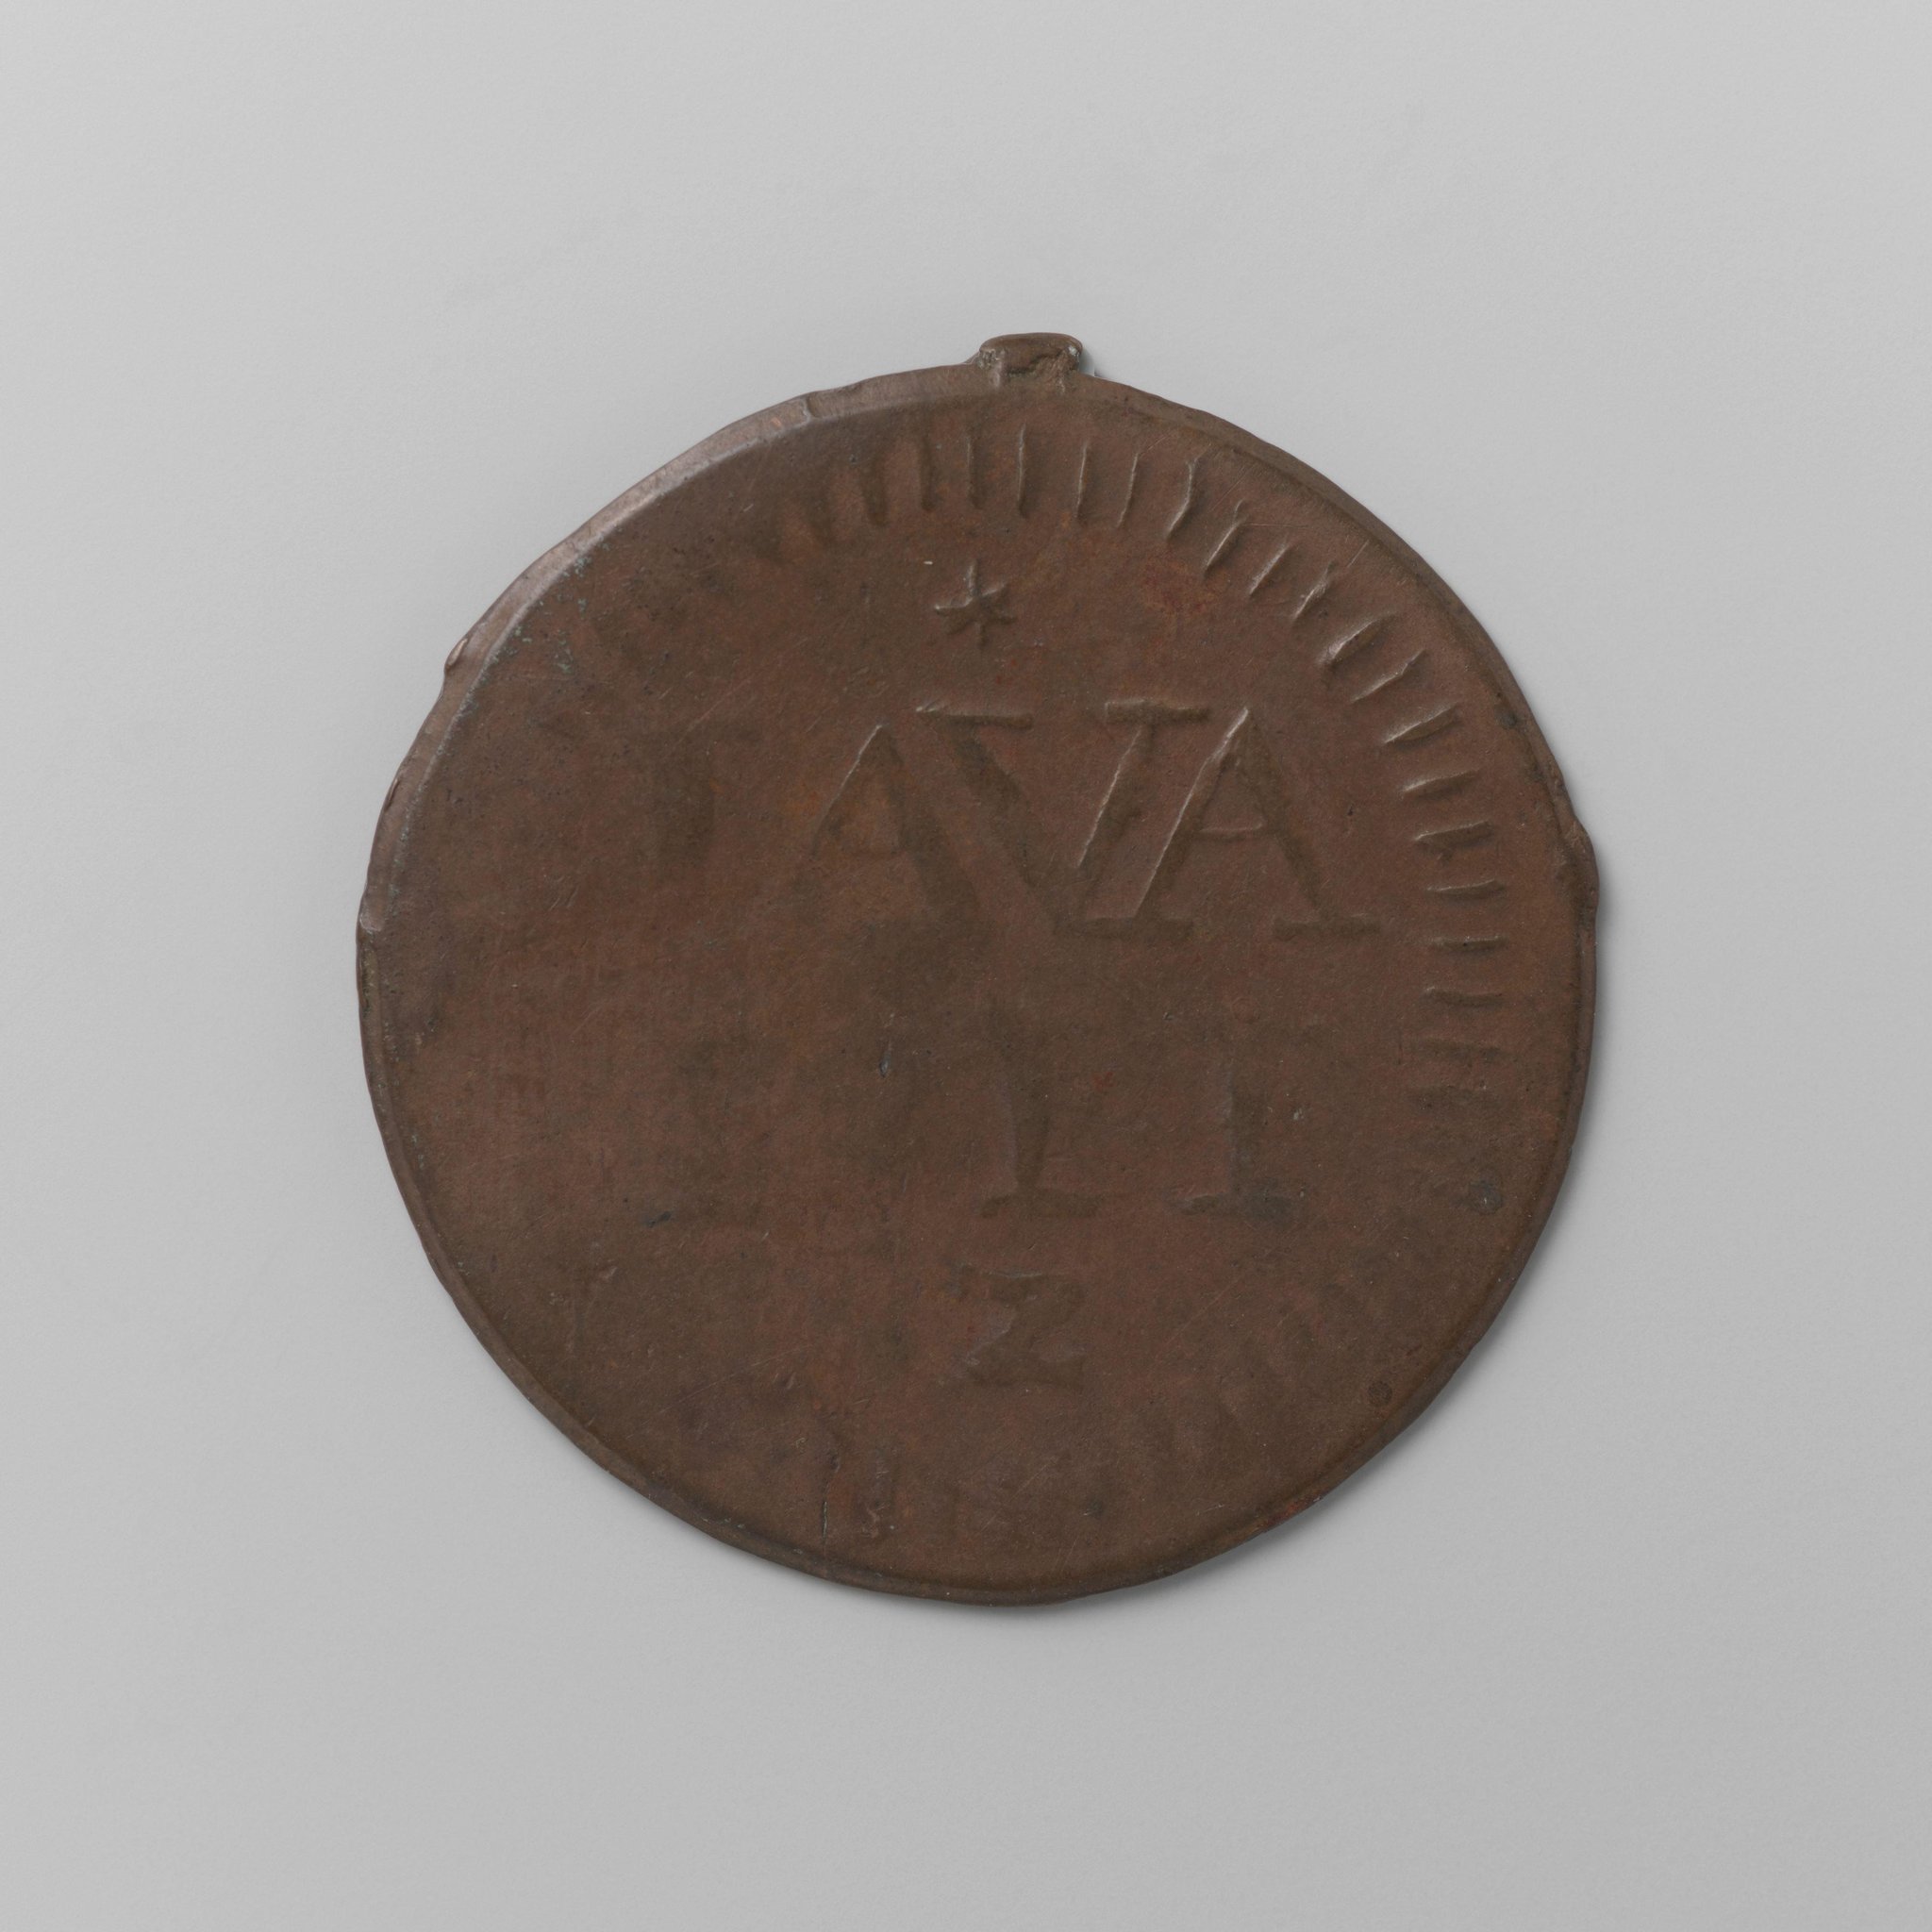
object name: coin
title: Nederlands Indië tijdens Brits bestuur, ½ stuiver Java,1811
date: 1811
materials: copper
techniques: striking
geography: surabaya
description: Koperen munt. Voorzijde: tussen waarde-aanduiding ½ St monogram van de Engelse Oostindische Compagnie. Daarboven letter B [=British]. Keerzijde: eenregelig opschrift, waaronder jaartal. Boven opschrift muntteken en onder jaartal muntmeesterteken Z [=muntmeester Zwekkert].